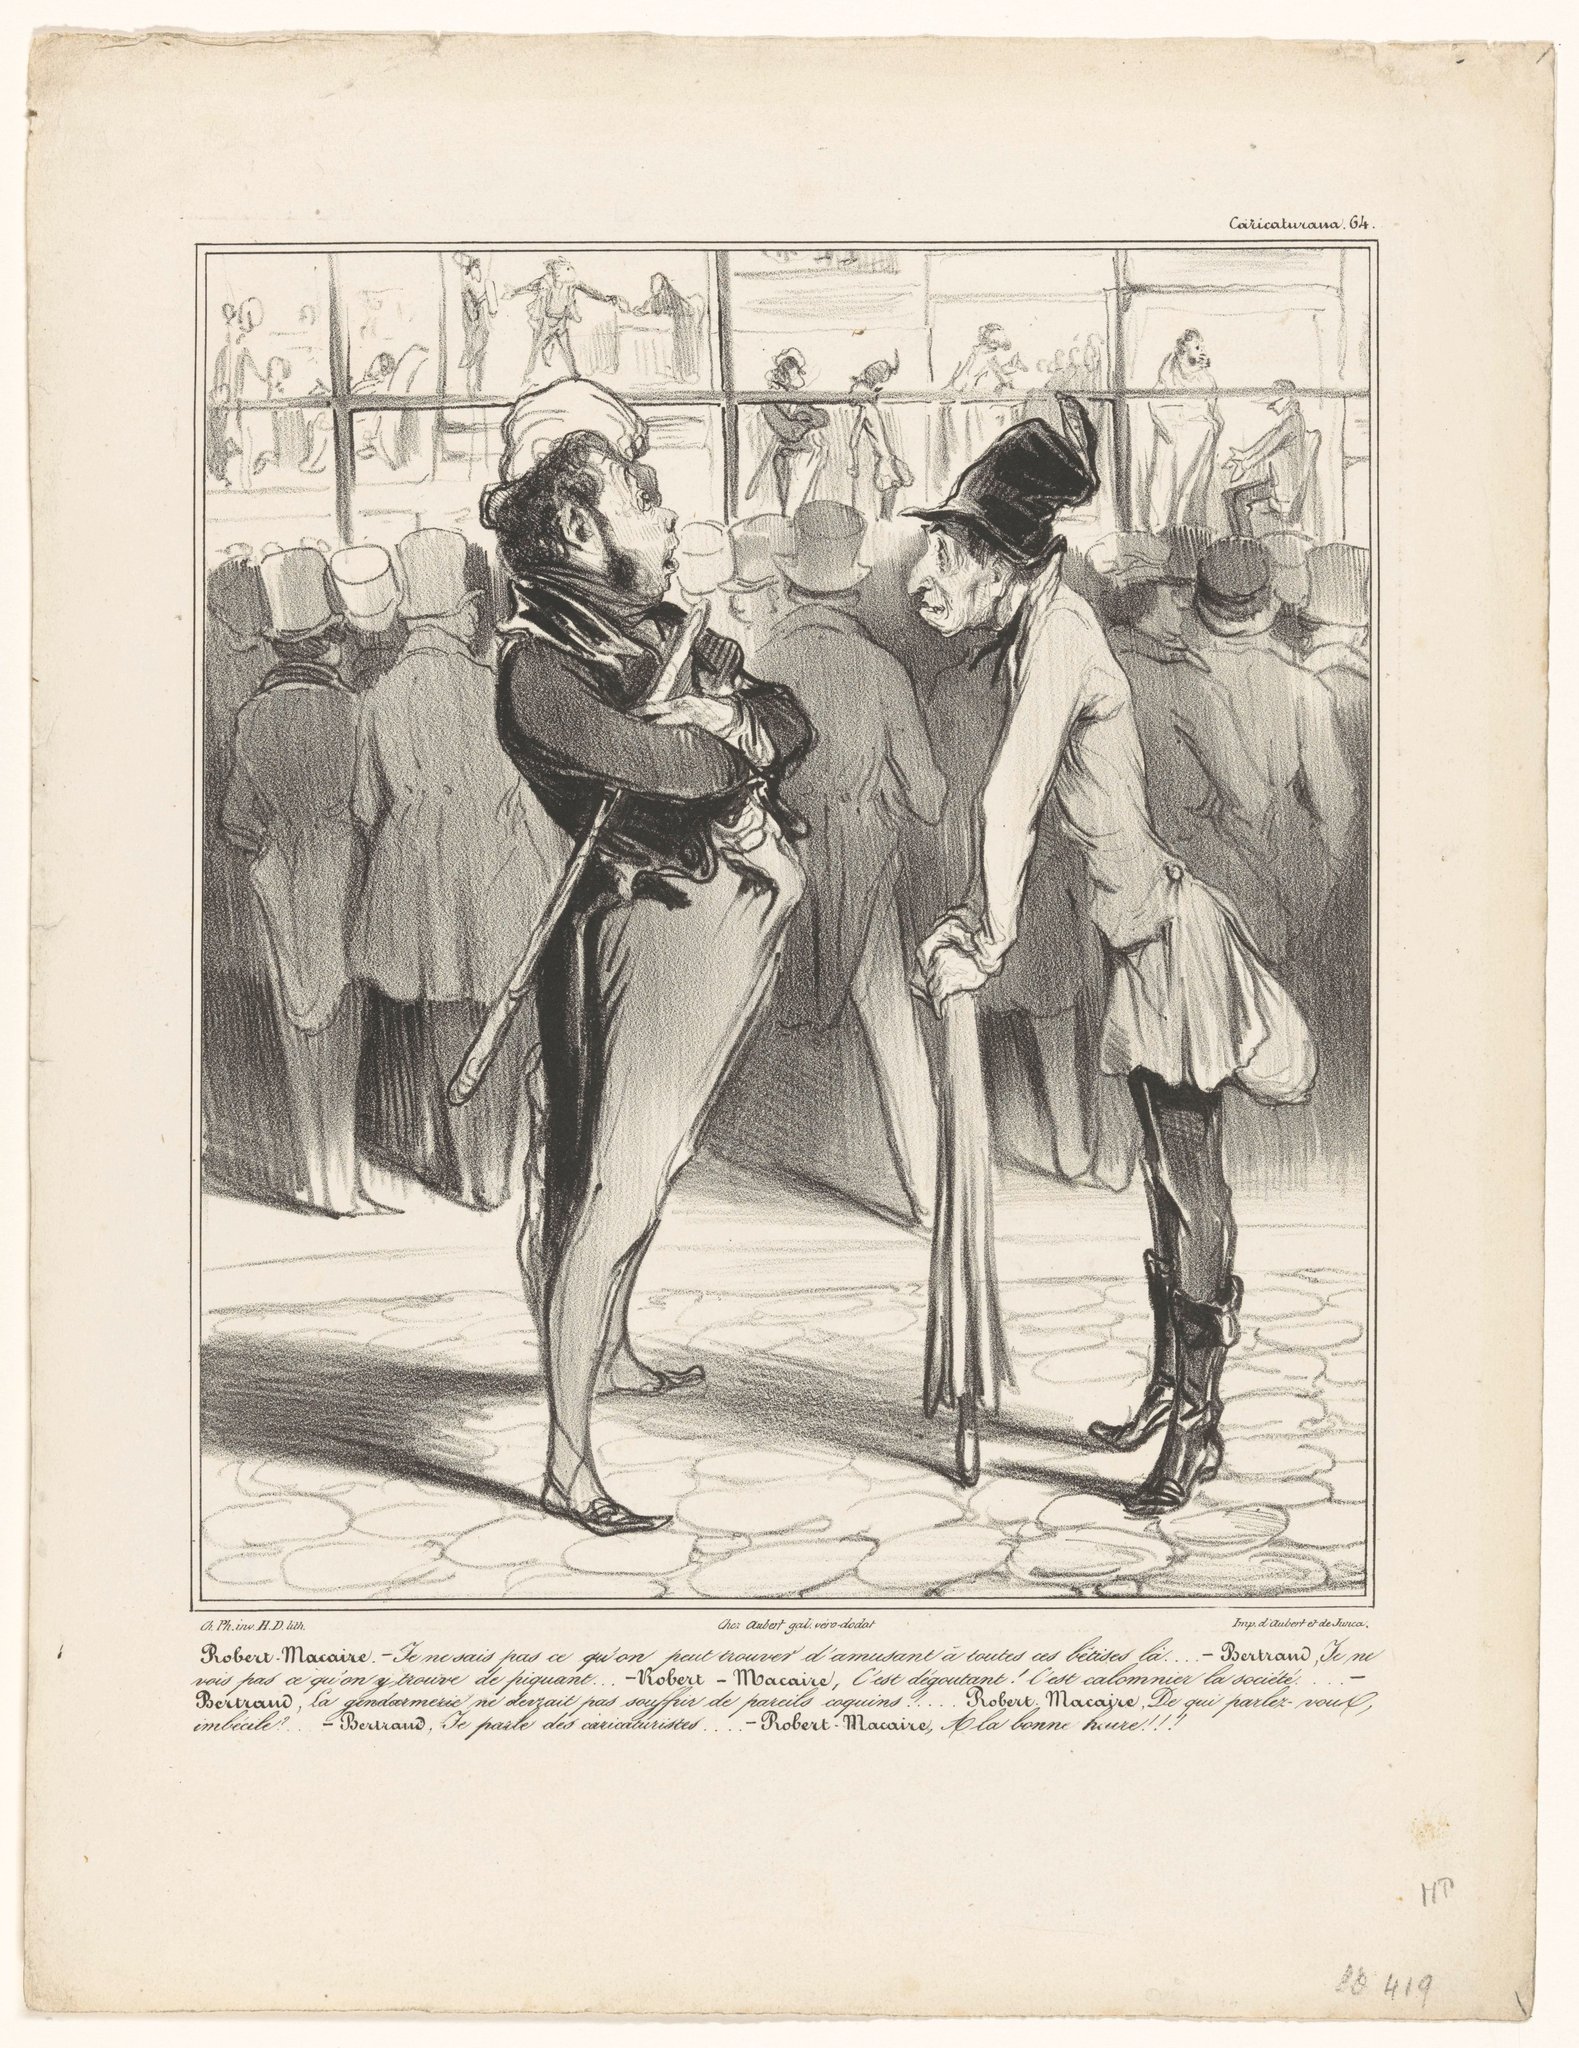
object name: print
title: Caricaturana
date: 1838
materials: paper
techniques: lithograph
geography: paris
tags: publishing, publisher, art dealer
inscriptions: collector's mark: Lugt 2228, collector's mark: Lugt 4780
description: Nummer 64 uit de serie Caricaturana, bestaande uit 100 prenten. Deze prenten verschenen voor het eerst in Le Charivari tussen 1836-1838 (deze prent oktober 1837), en werden in 1838 gebundeld onder de titel: Les Robert-Macaires. Een van de prenten in de etalage toont deze voorstelling.